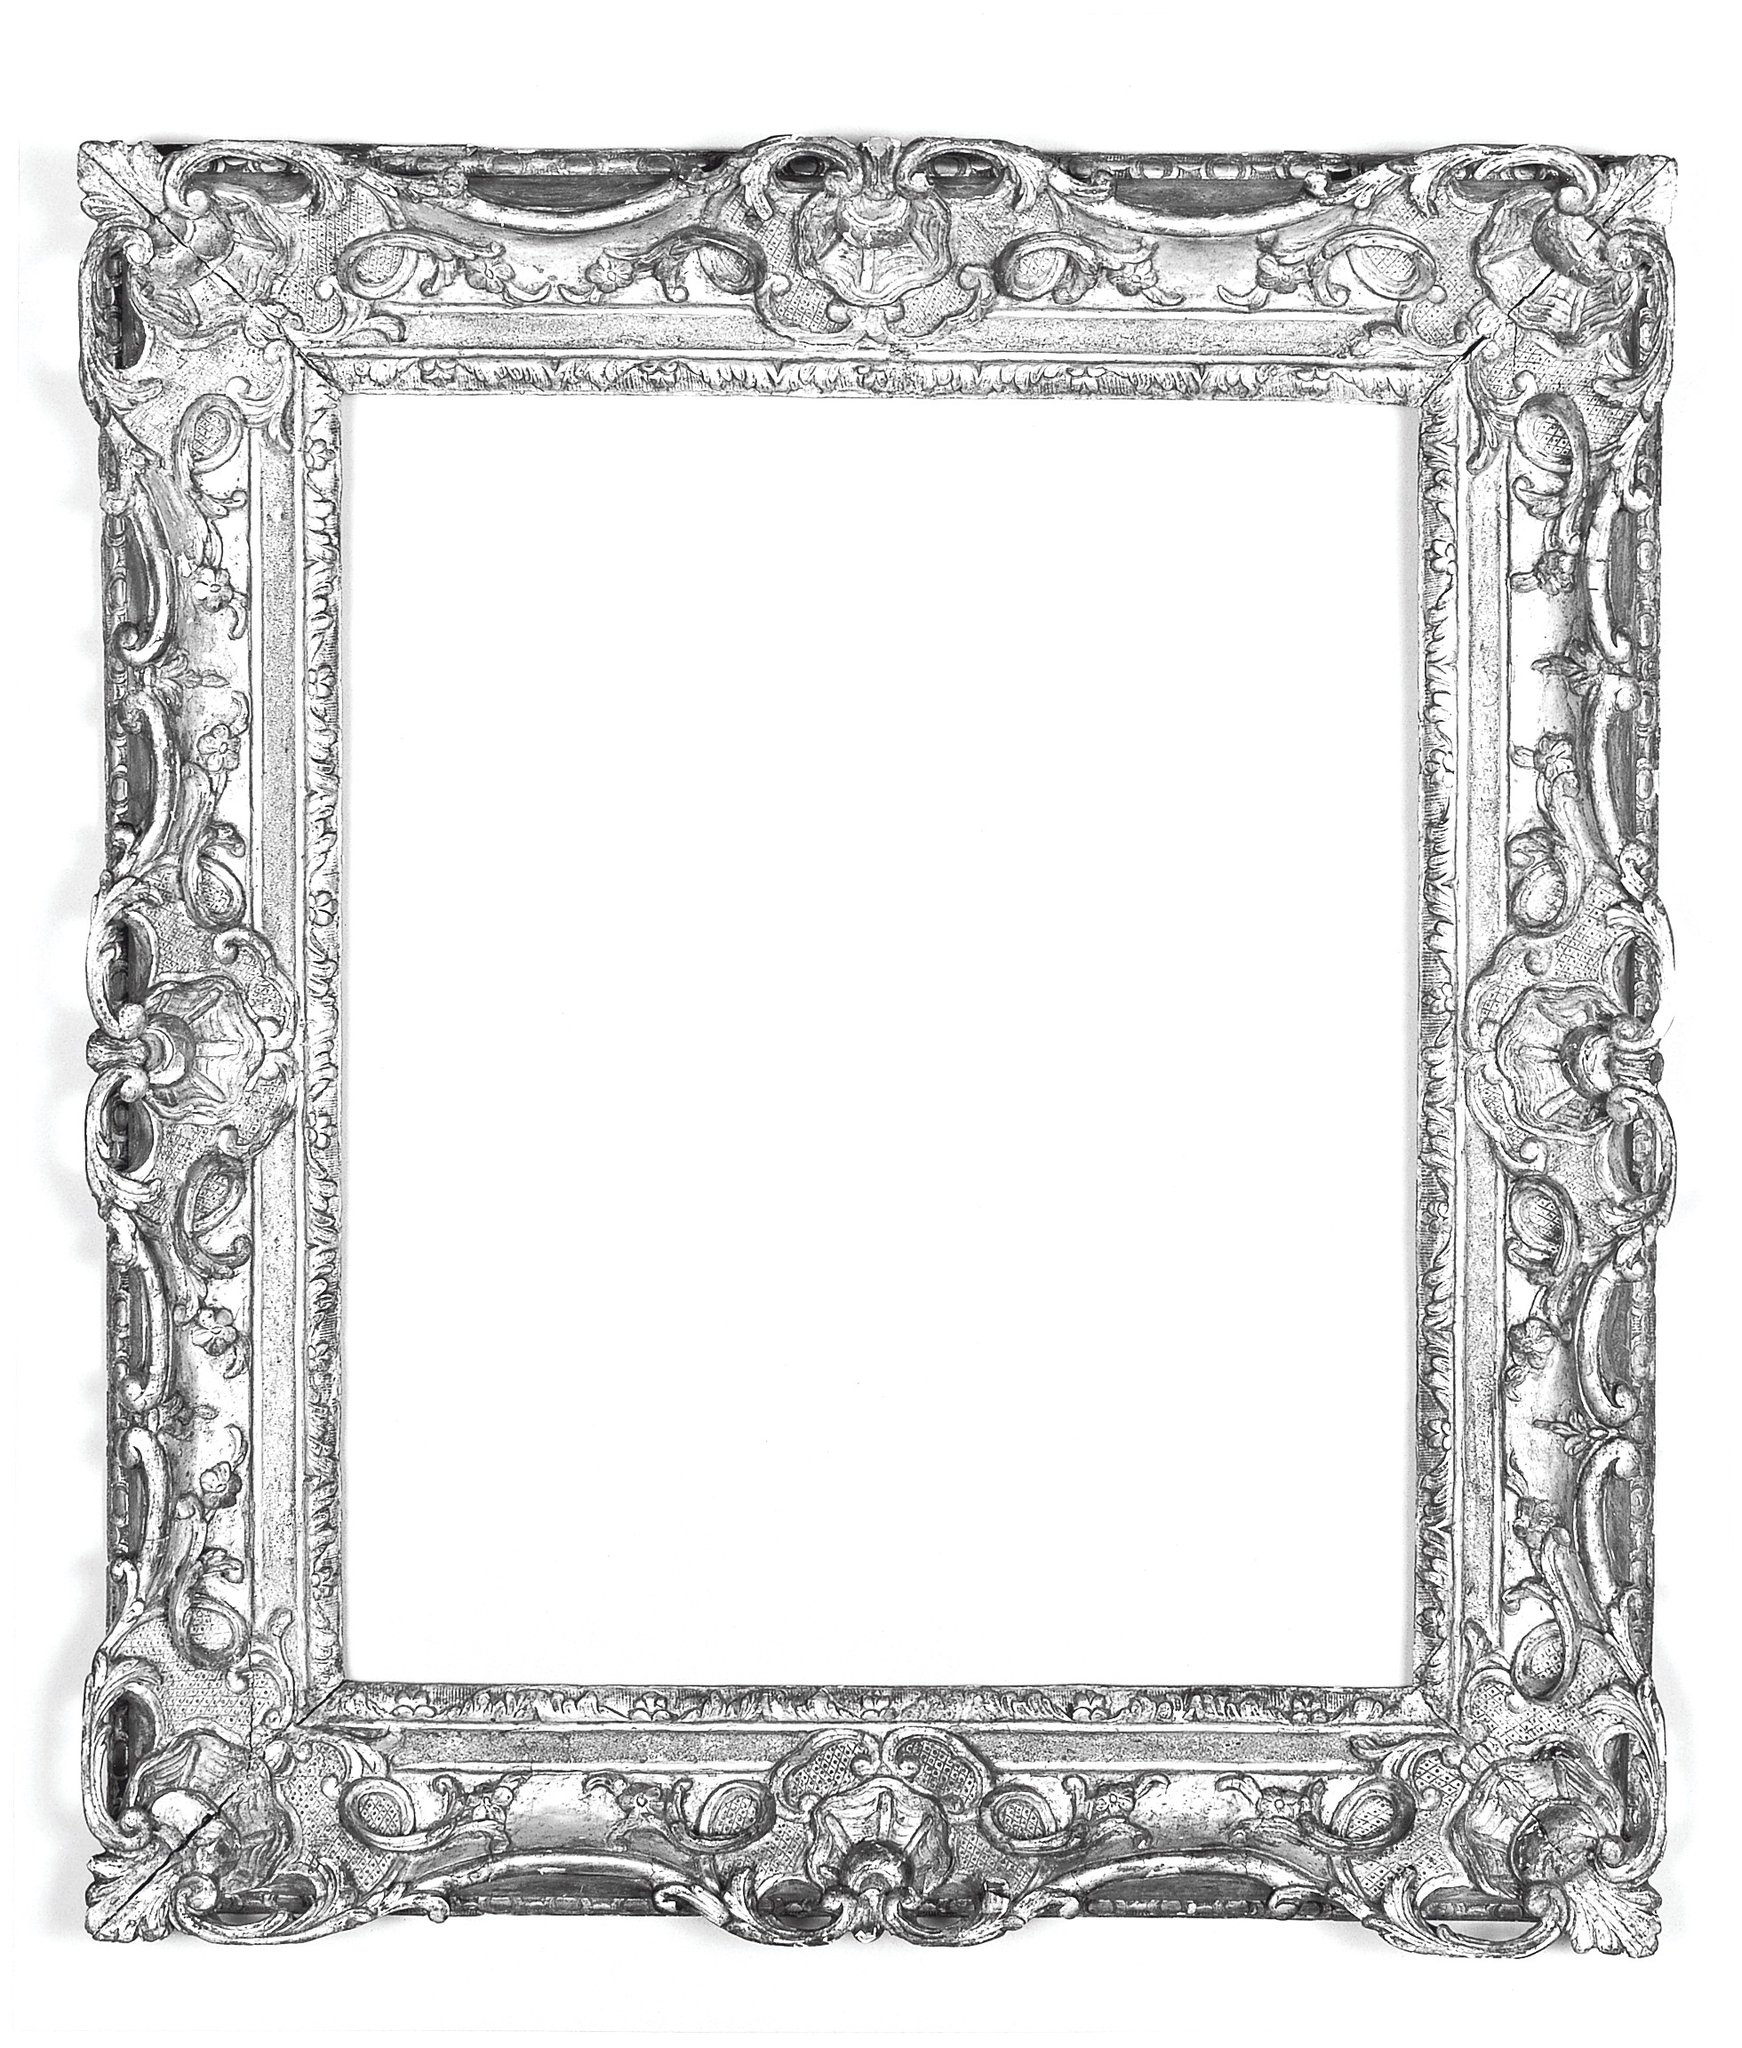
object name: frame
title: Swept frame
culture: french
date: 1735-1745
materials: wood